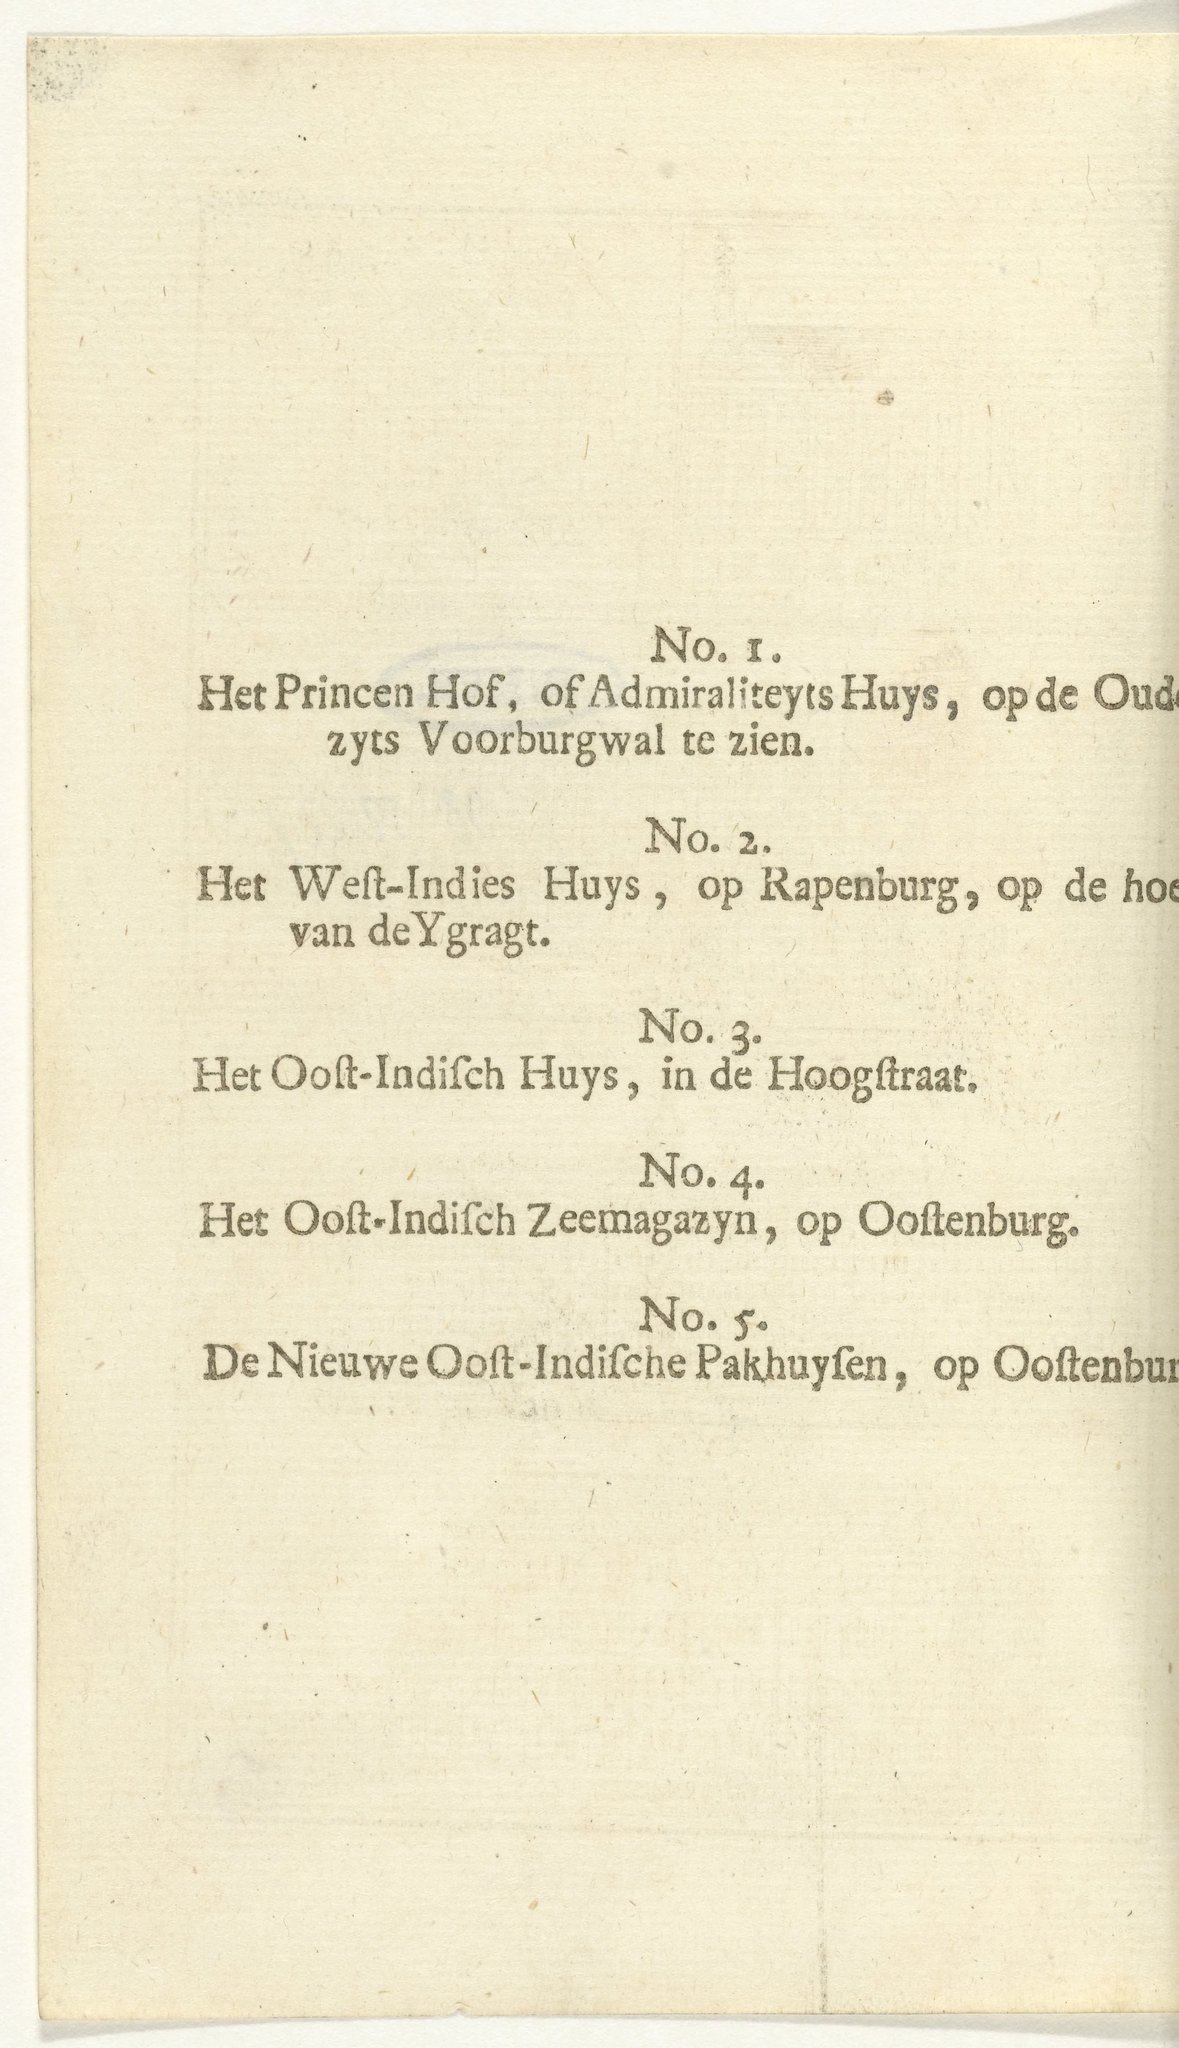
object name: text sheet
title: Tekstblad bij boekillustratie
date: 1723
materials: paper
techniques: letterpress printing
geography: amsterdam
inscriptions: collector's mark: Lugt 2228, collector's mark: Lugt 2760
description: Tekstblad uit: Leuve, Roeland van. 's Waerelds koopslot of De Amsteldamse beurs. Amsterdam: Jacobus Verheyden (I), 1723.